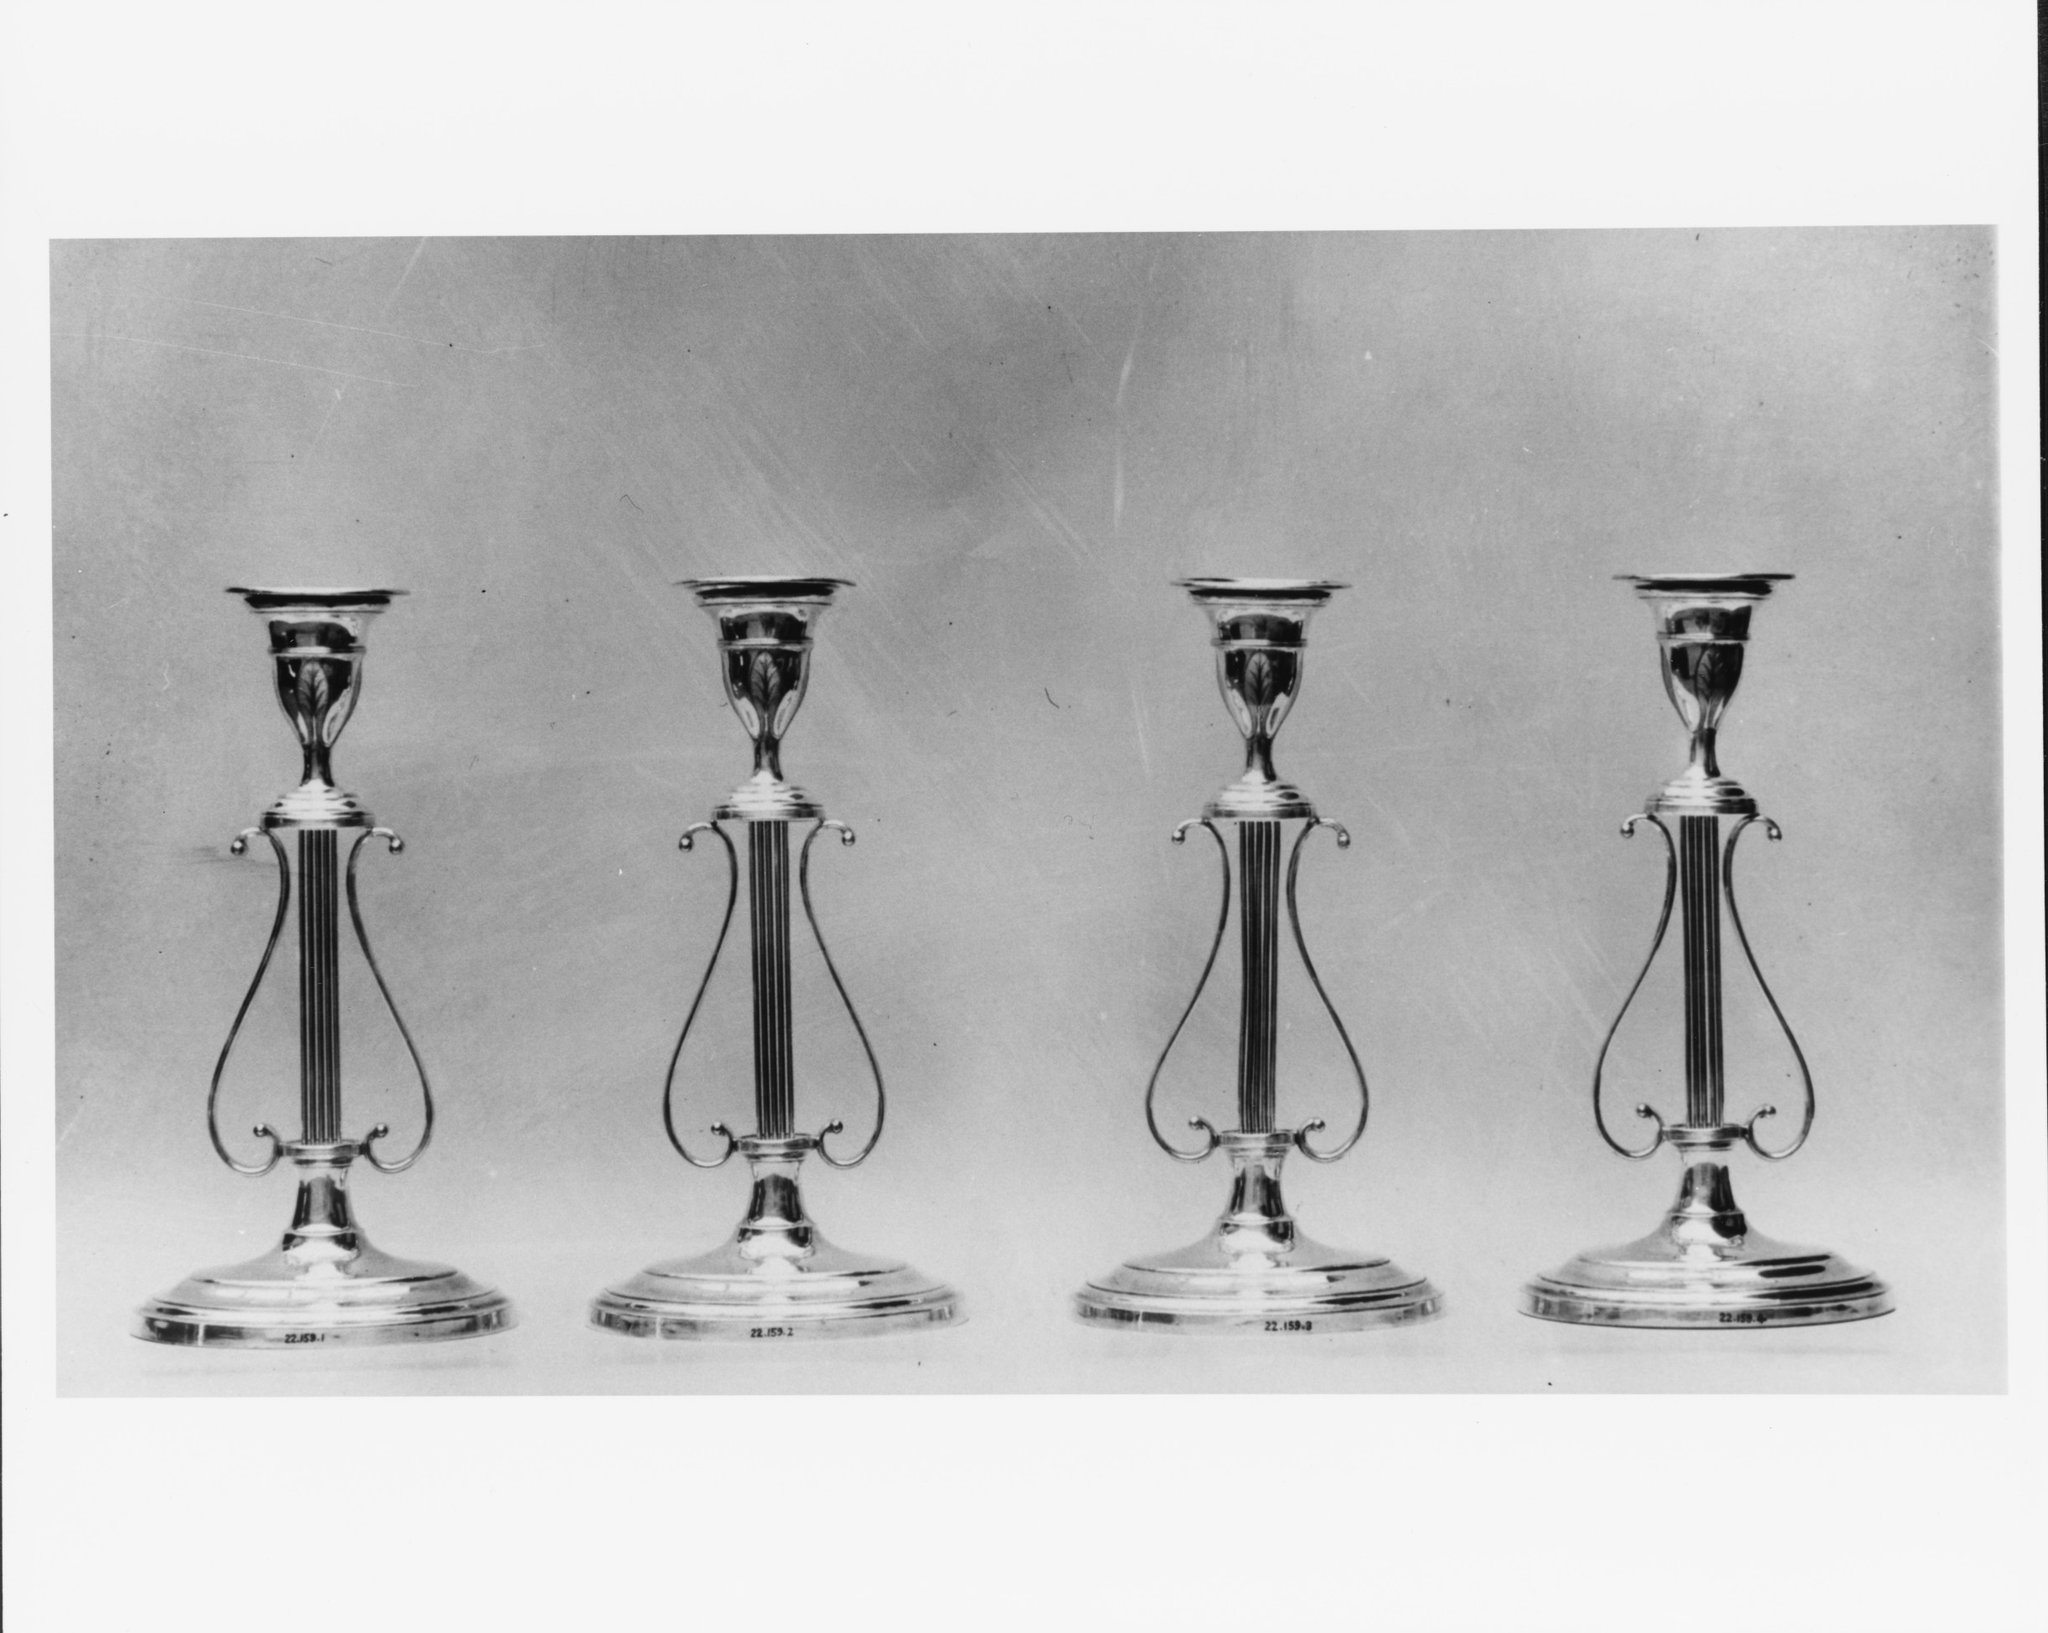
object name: candlestick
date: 1800-1830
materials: copper, silver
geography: england